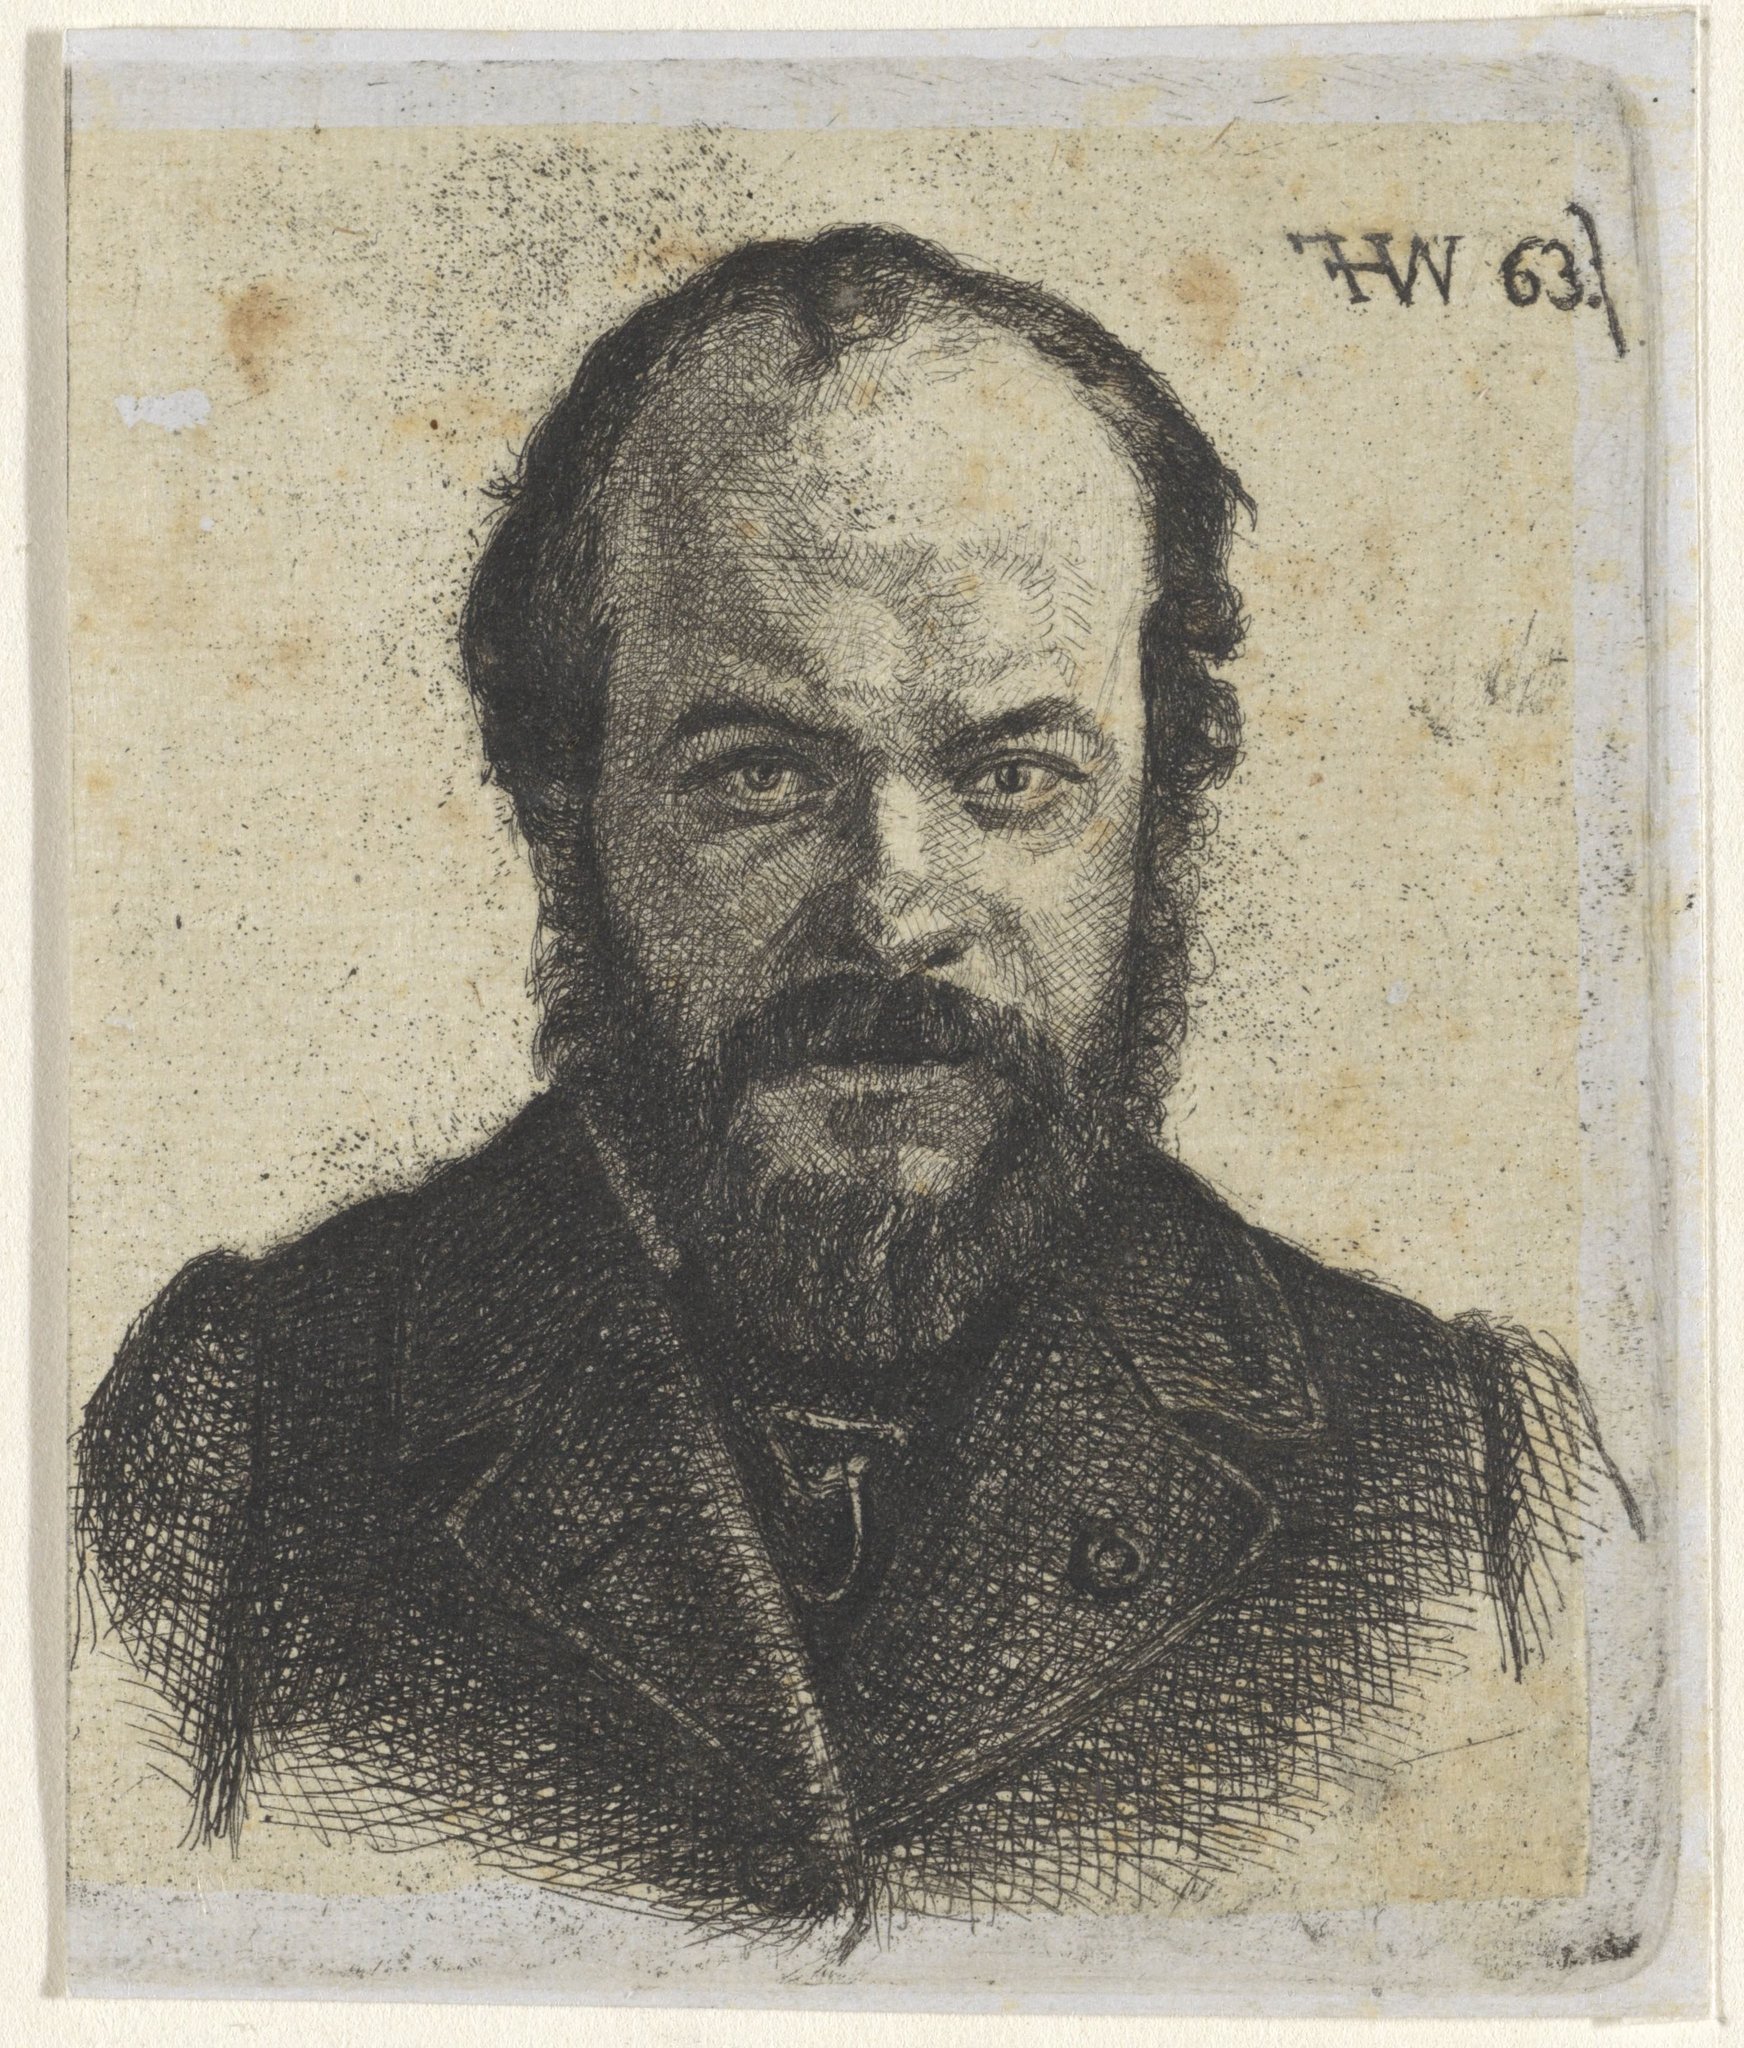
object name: print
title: Portret van Jan Weissenbruch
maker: frederik hendrik weissenbruch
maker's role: draughtsman, print maker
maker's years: 1828-1887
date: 1863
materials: paper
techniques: etching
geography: the hague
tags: painter, jan weissenbruch, historical persons, portrait, self-portrait of artist, beard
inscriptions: collector's mark: Lugt 2228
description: Portret van de kunstenaar Jan Weissenbruch, oudere broer en leermeester van de vervaardigend kunstenaar.